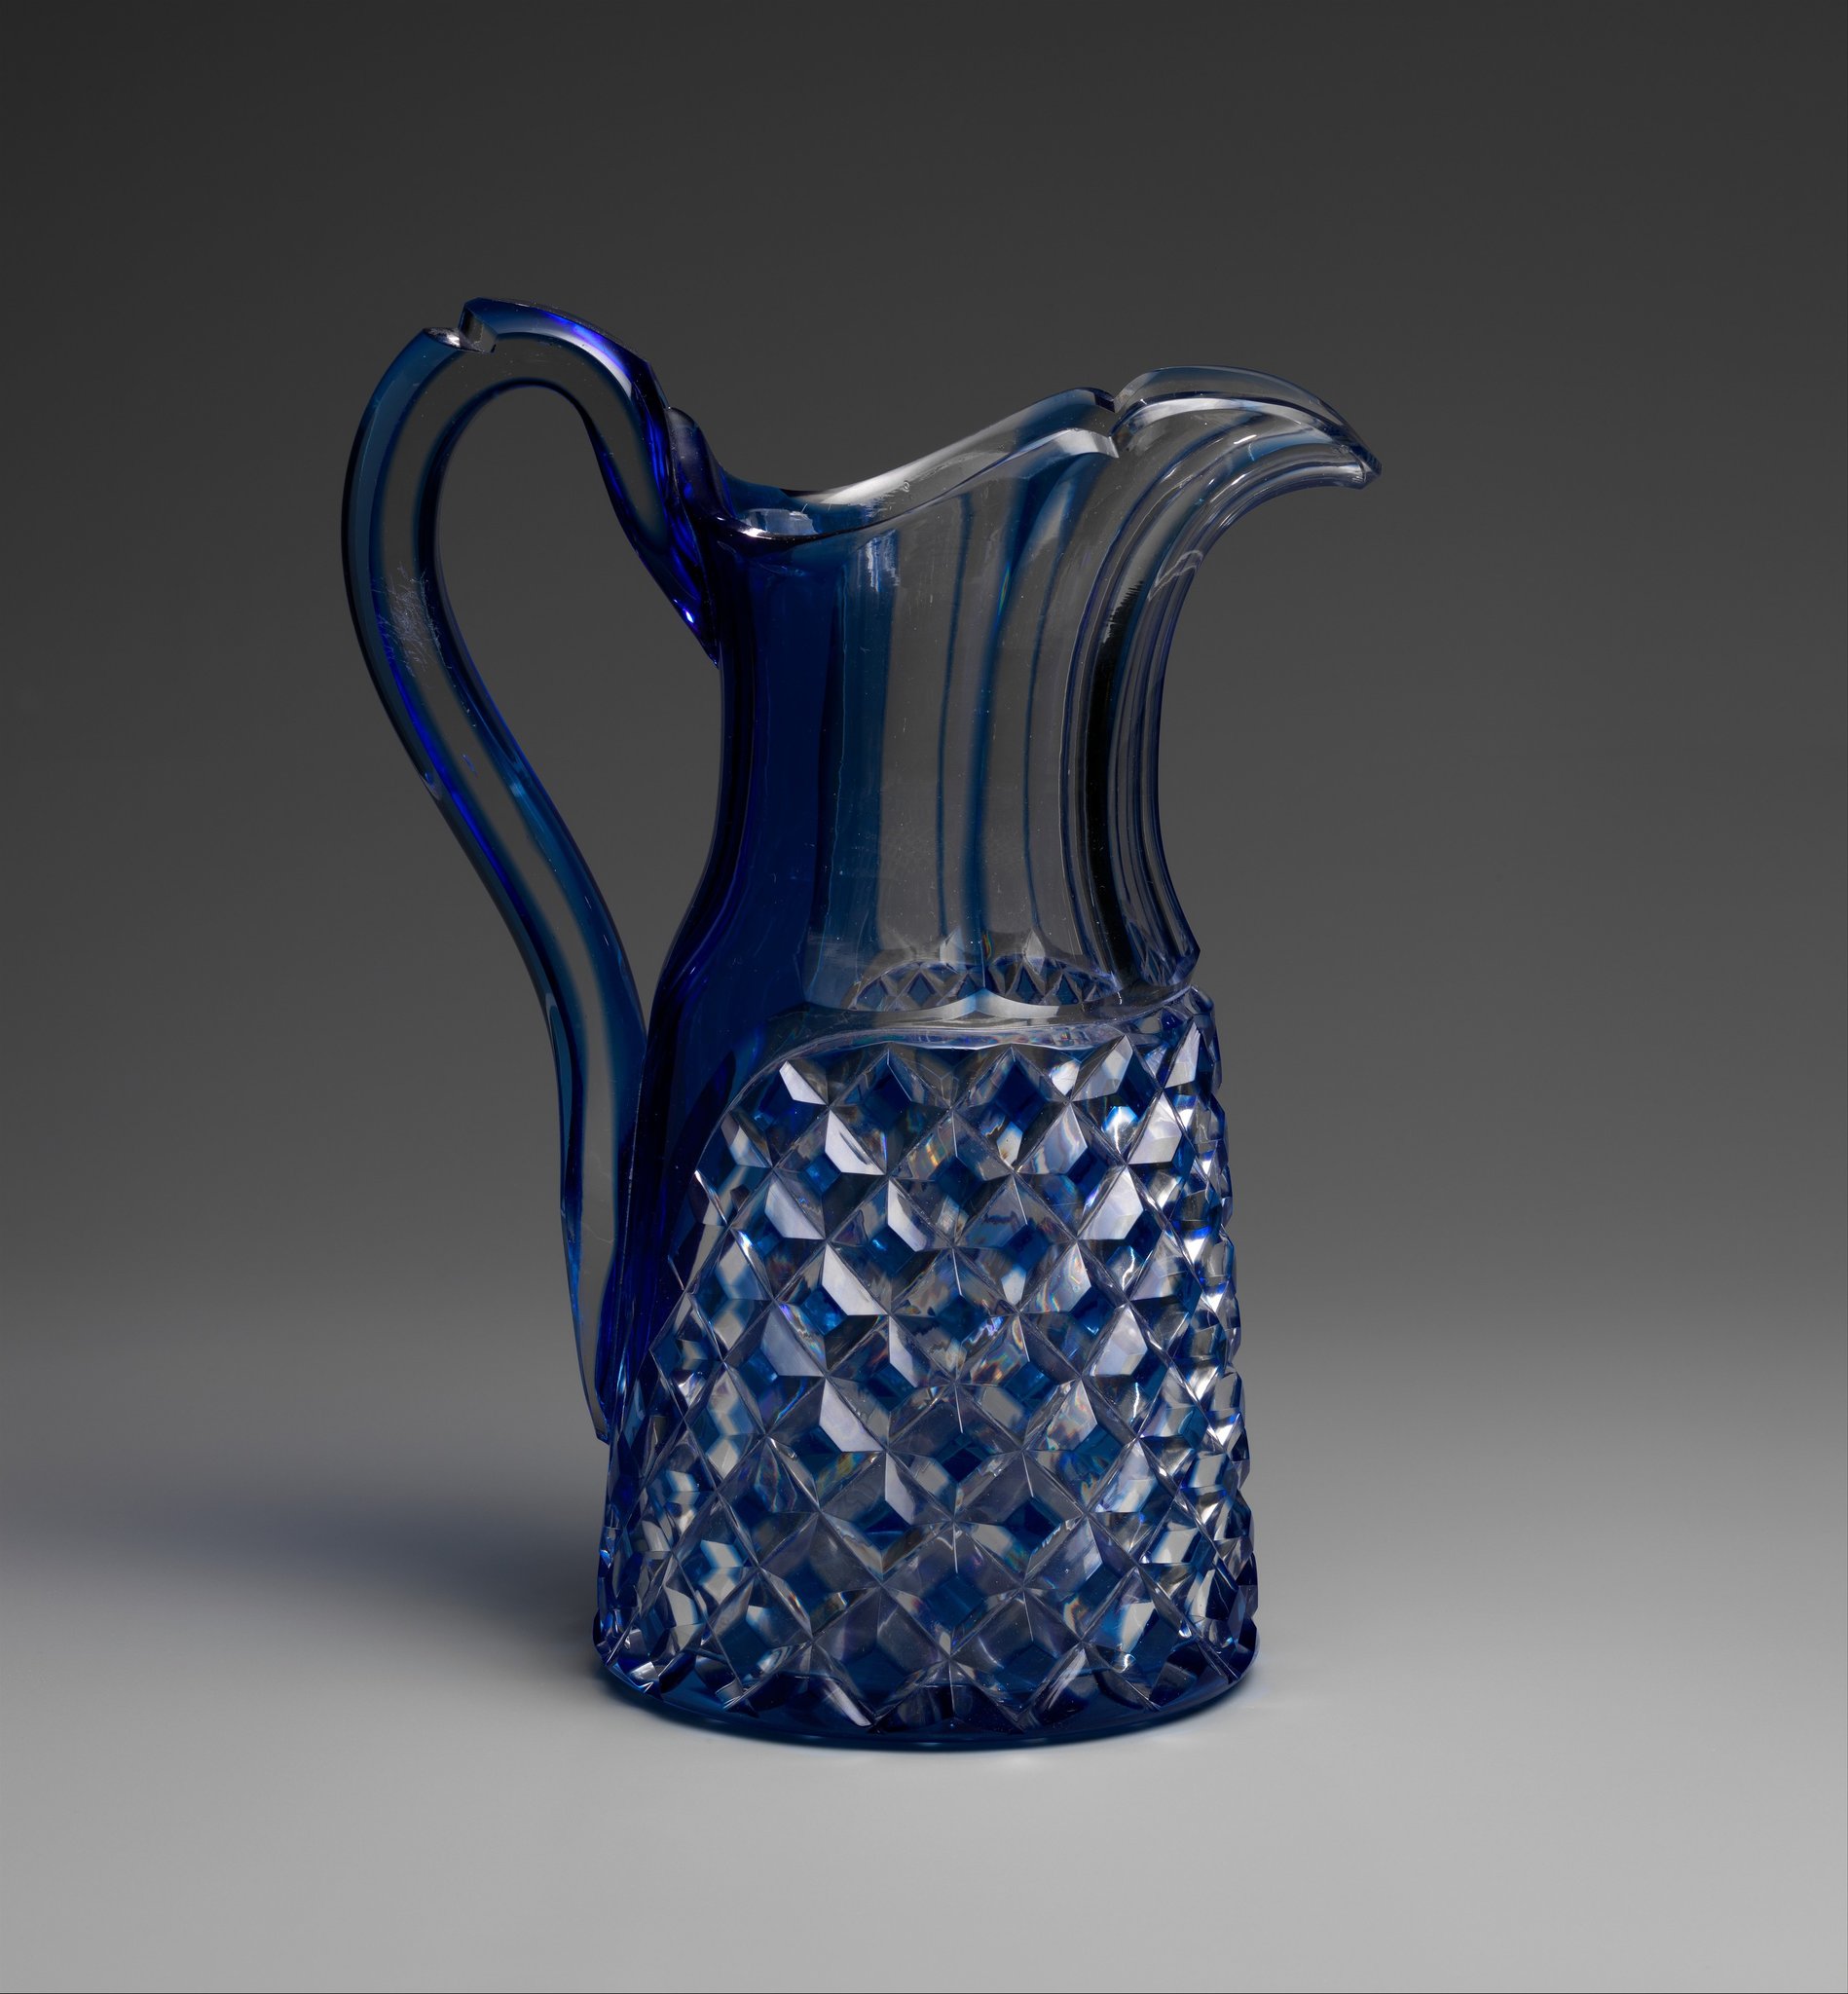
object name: pitcher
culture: american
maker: brooklyn flint glass company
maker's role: manufacturer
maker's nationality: american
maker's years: 1824-1868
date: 1850-1855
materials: glass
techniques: cutting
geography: united states